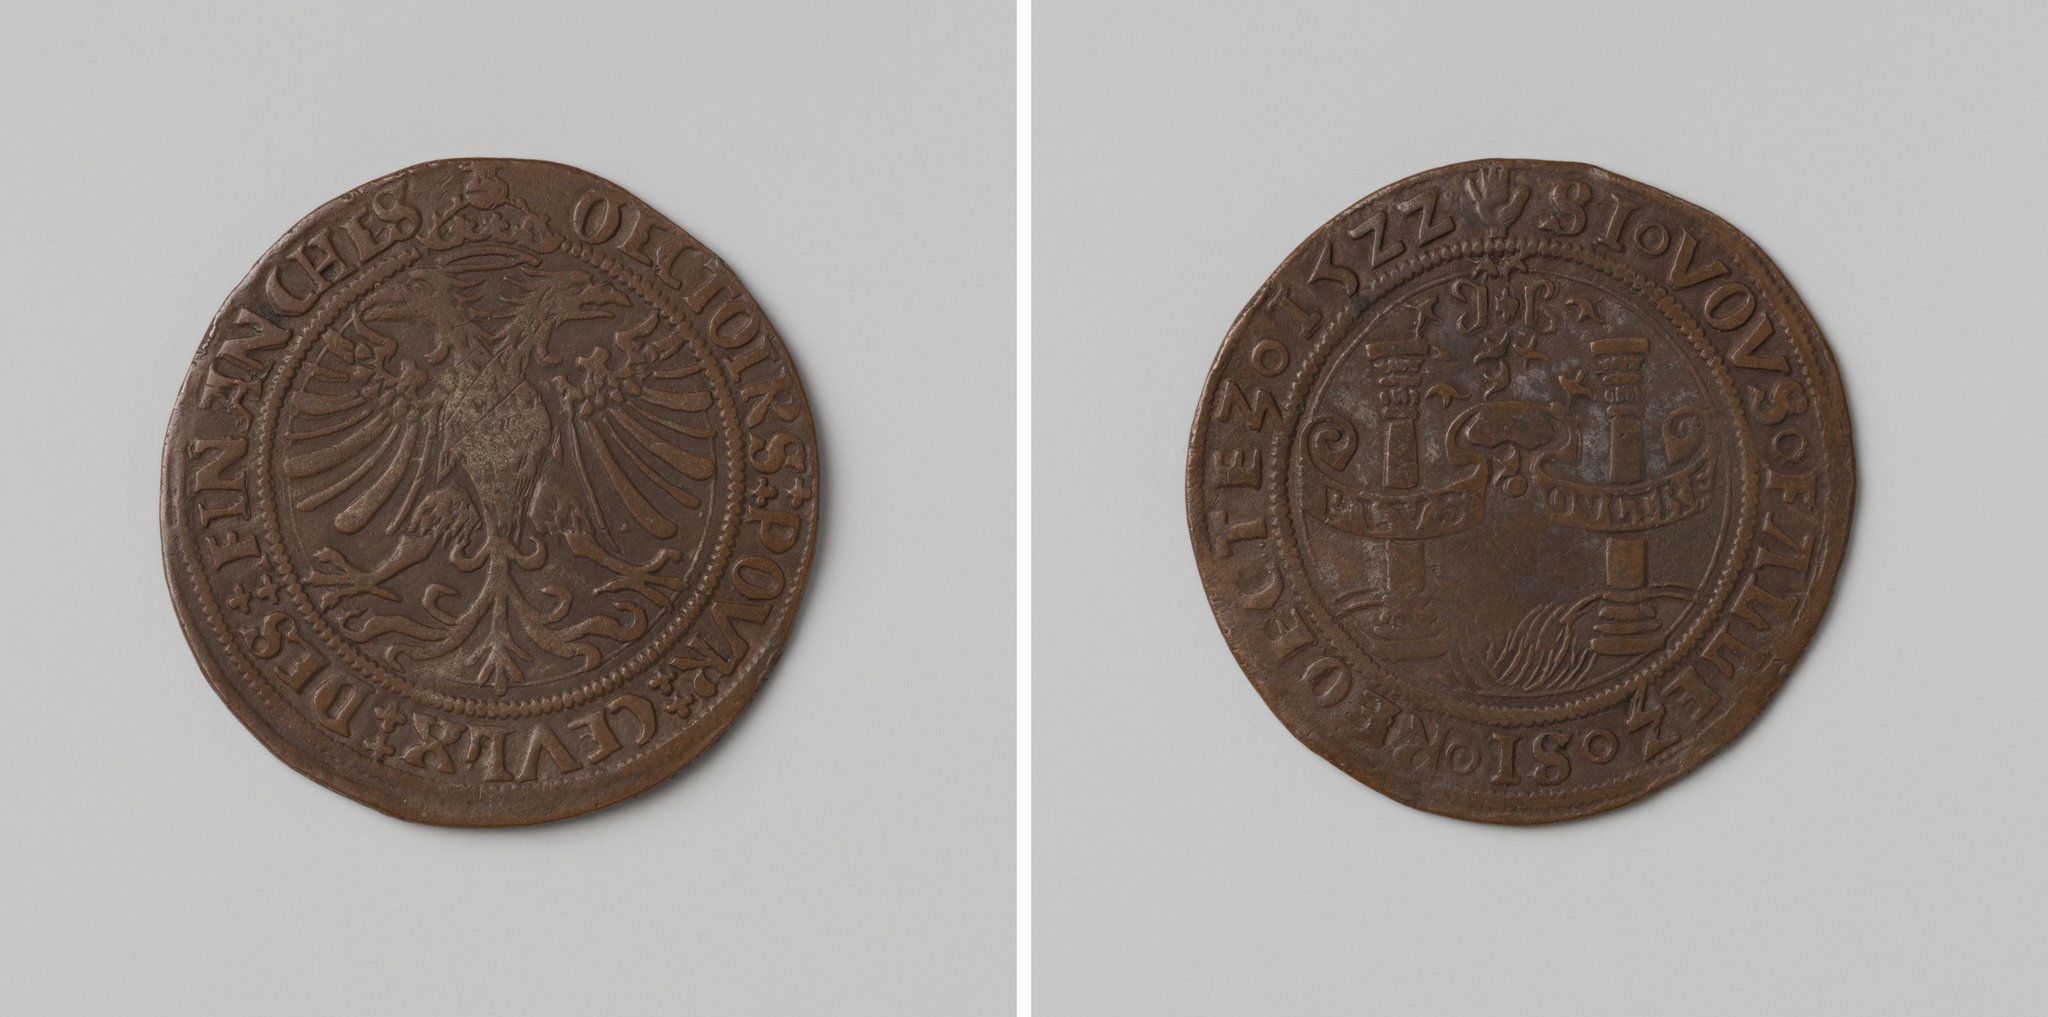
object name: jeton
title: Karel V, Duits keizer, rekenpenning van de raad van Financiën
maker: Anonymous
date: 1522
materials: copper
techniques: striking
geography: antwerp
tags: ghent, charles v (holy roman emperor and king of spain)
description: Koperen penning. Voorzijde: tweekoppige adelaar onder kroon binnen omschrift. Keerzijde: zuilen van Herkules, verbonden door wimpel met opschrift onder twee naar elkaar gewende vuurslagen binnen omschrift